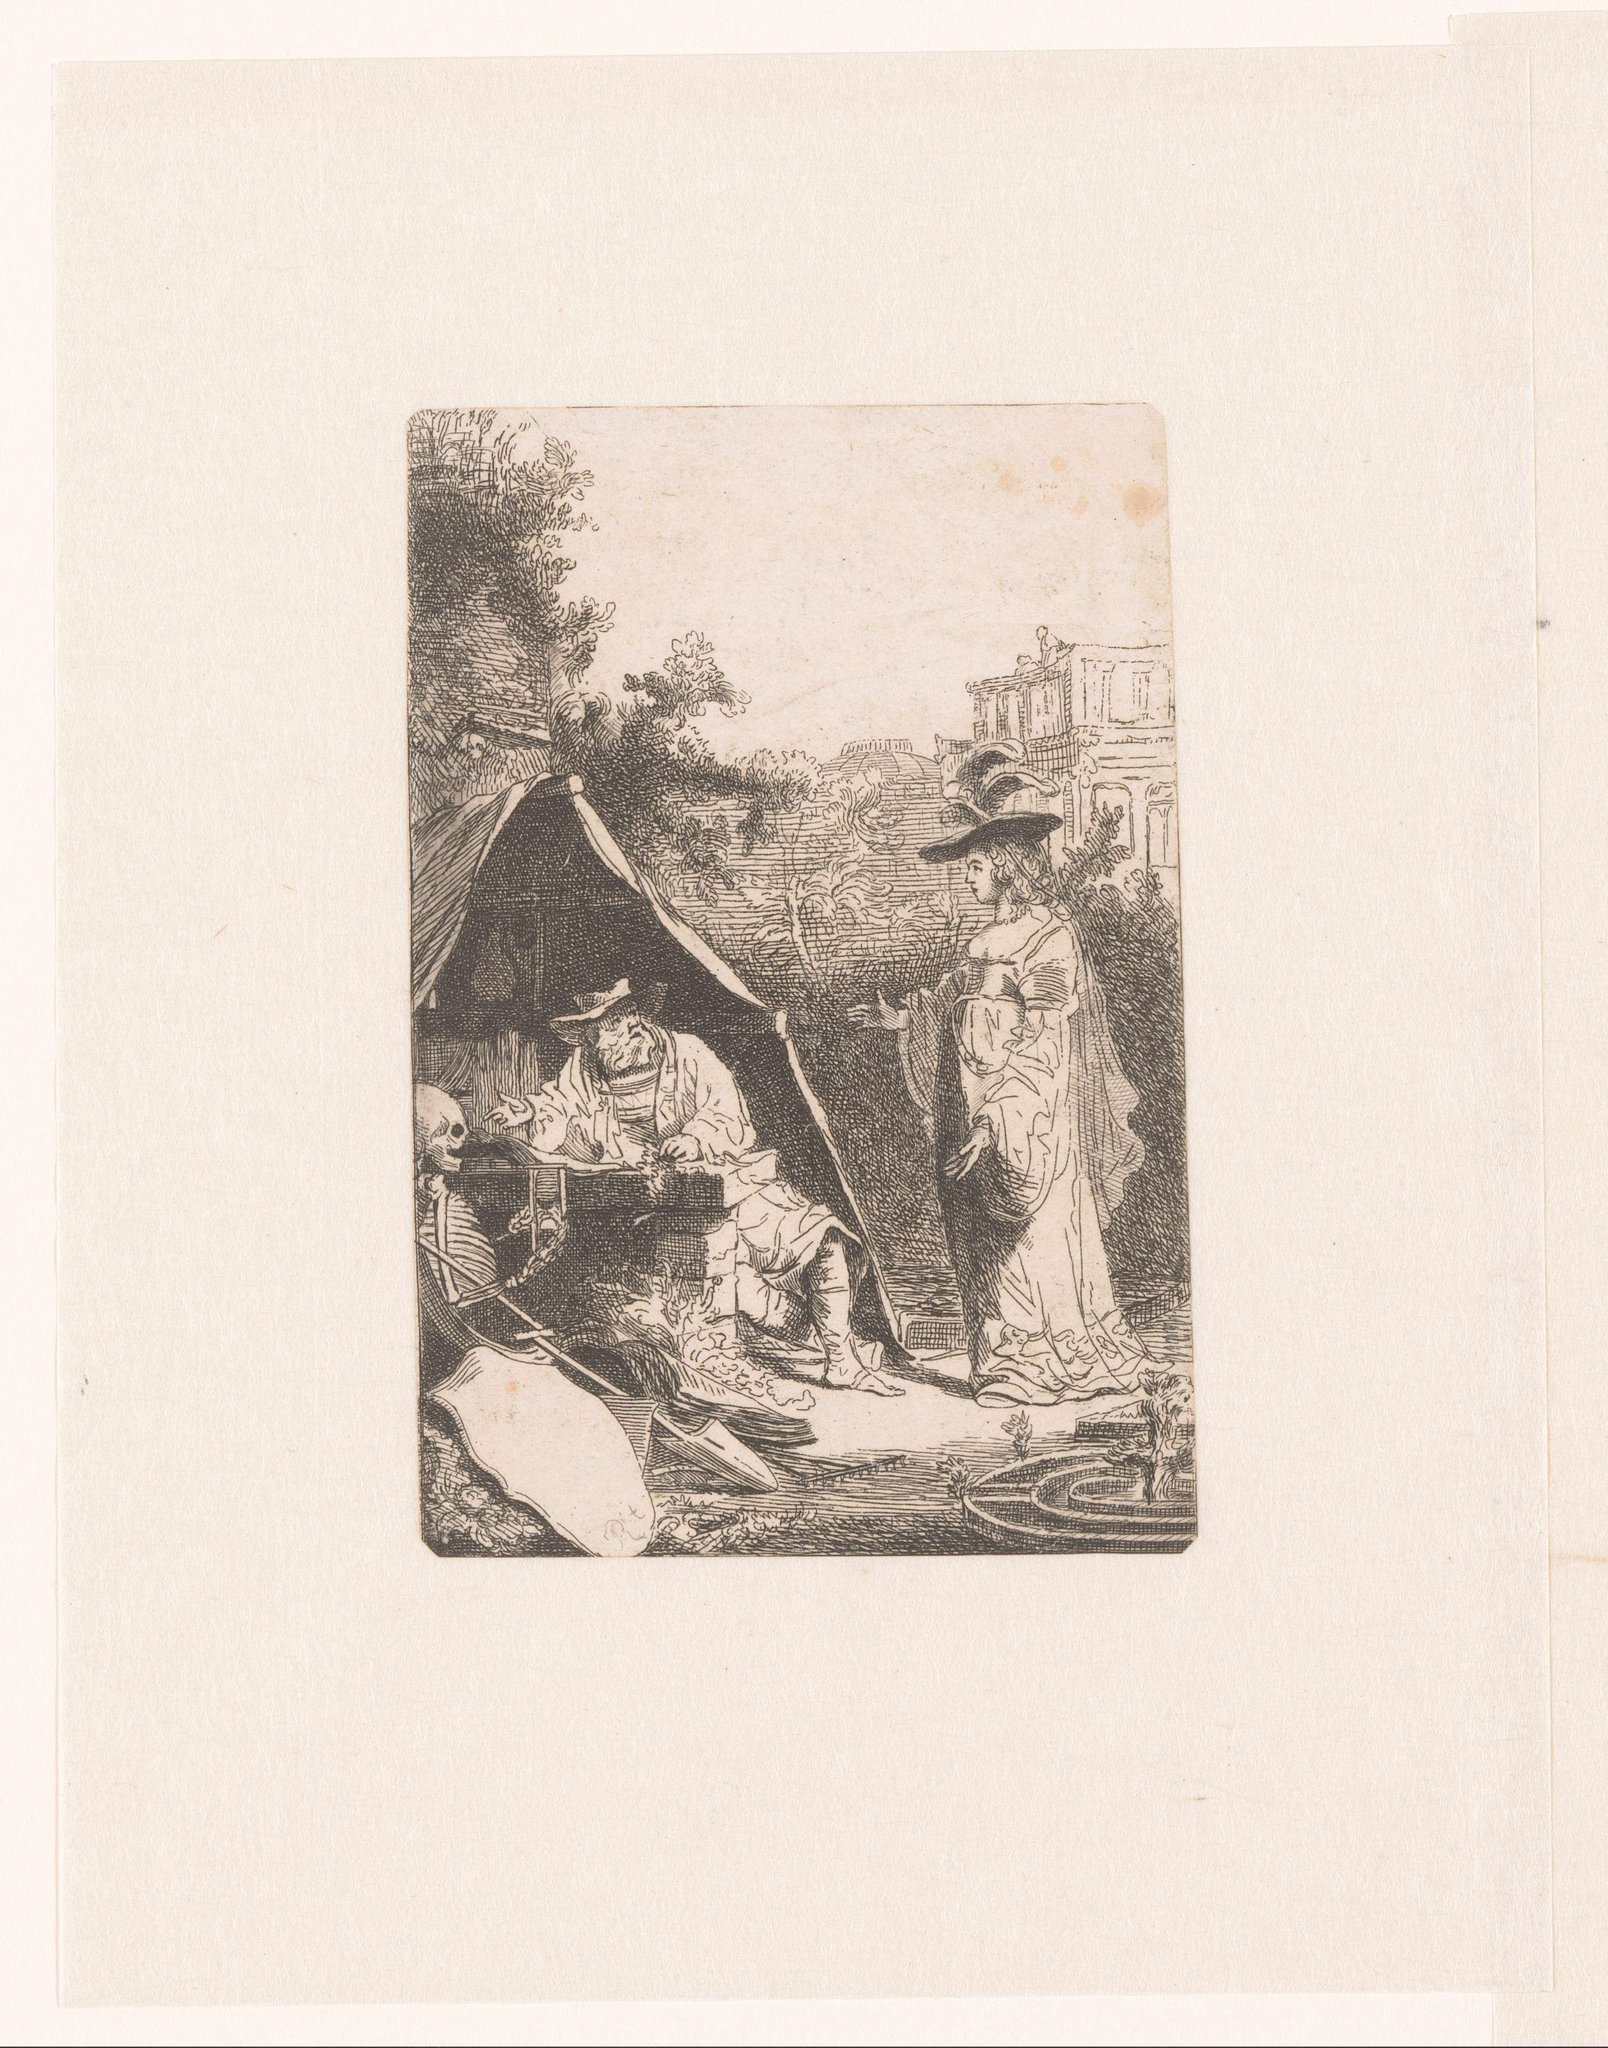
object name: print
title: Jonge vrouw en oude man met De Dood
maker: james hazard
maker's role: print maker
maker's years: 1748-1787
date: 1758-1787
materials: paper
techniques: etching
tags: dance of death; death together with one or more human beings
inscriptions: collector's mark: Lugt 2228, collector's mark: Lugt 2760